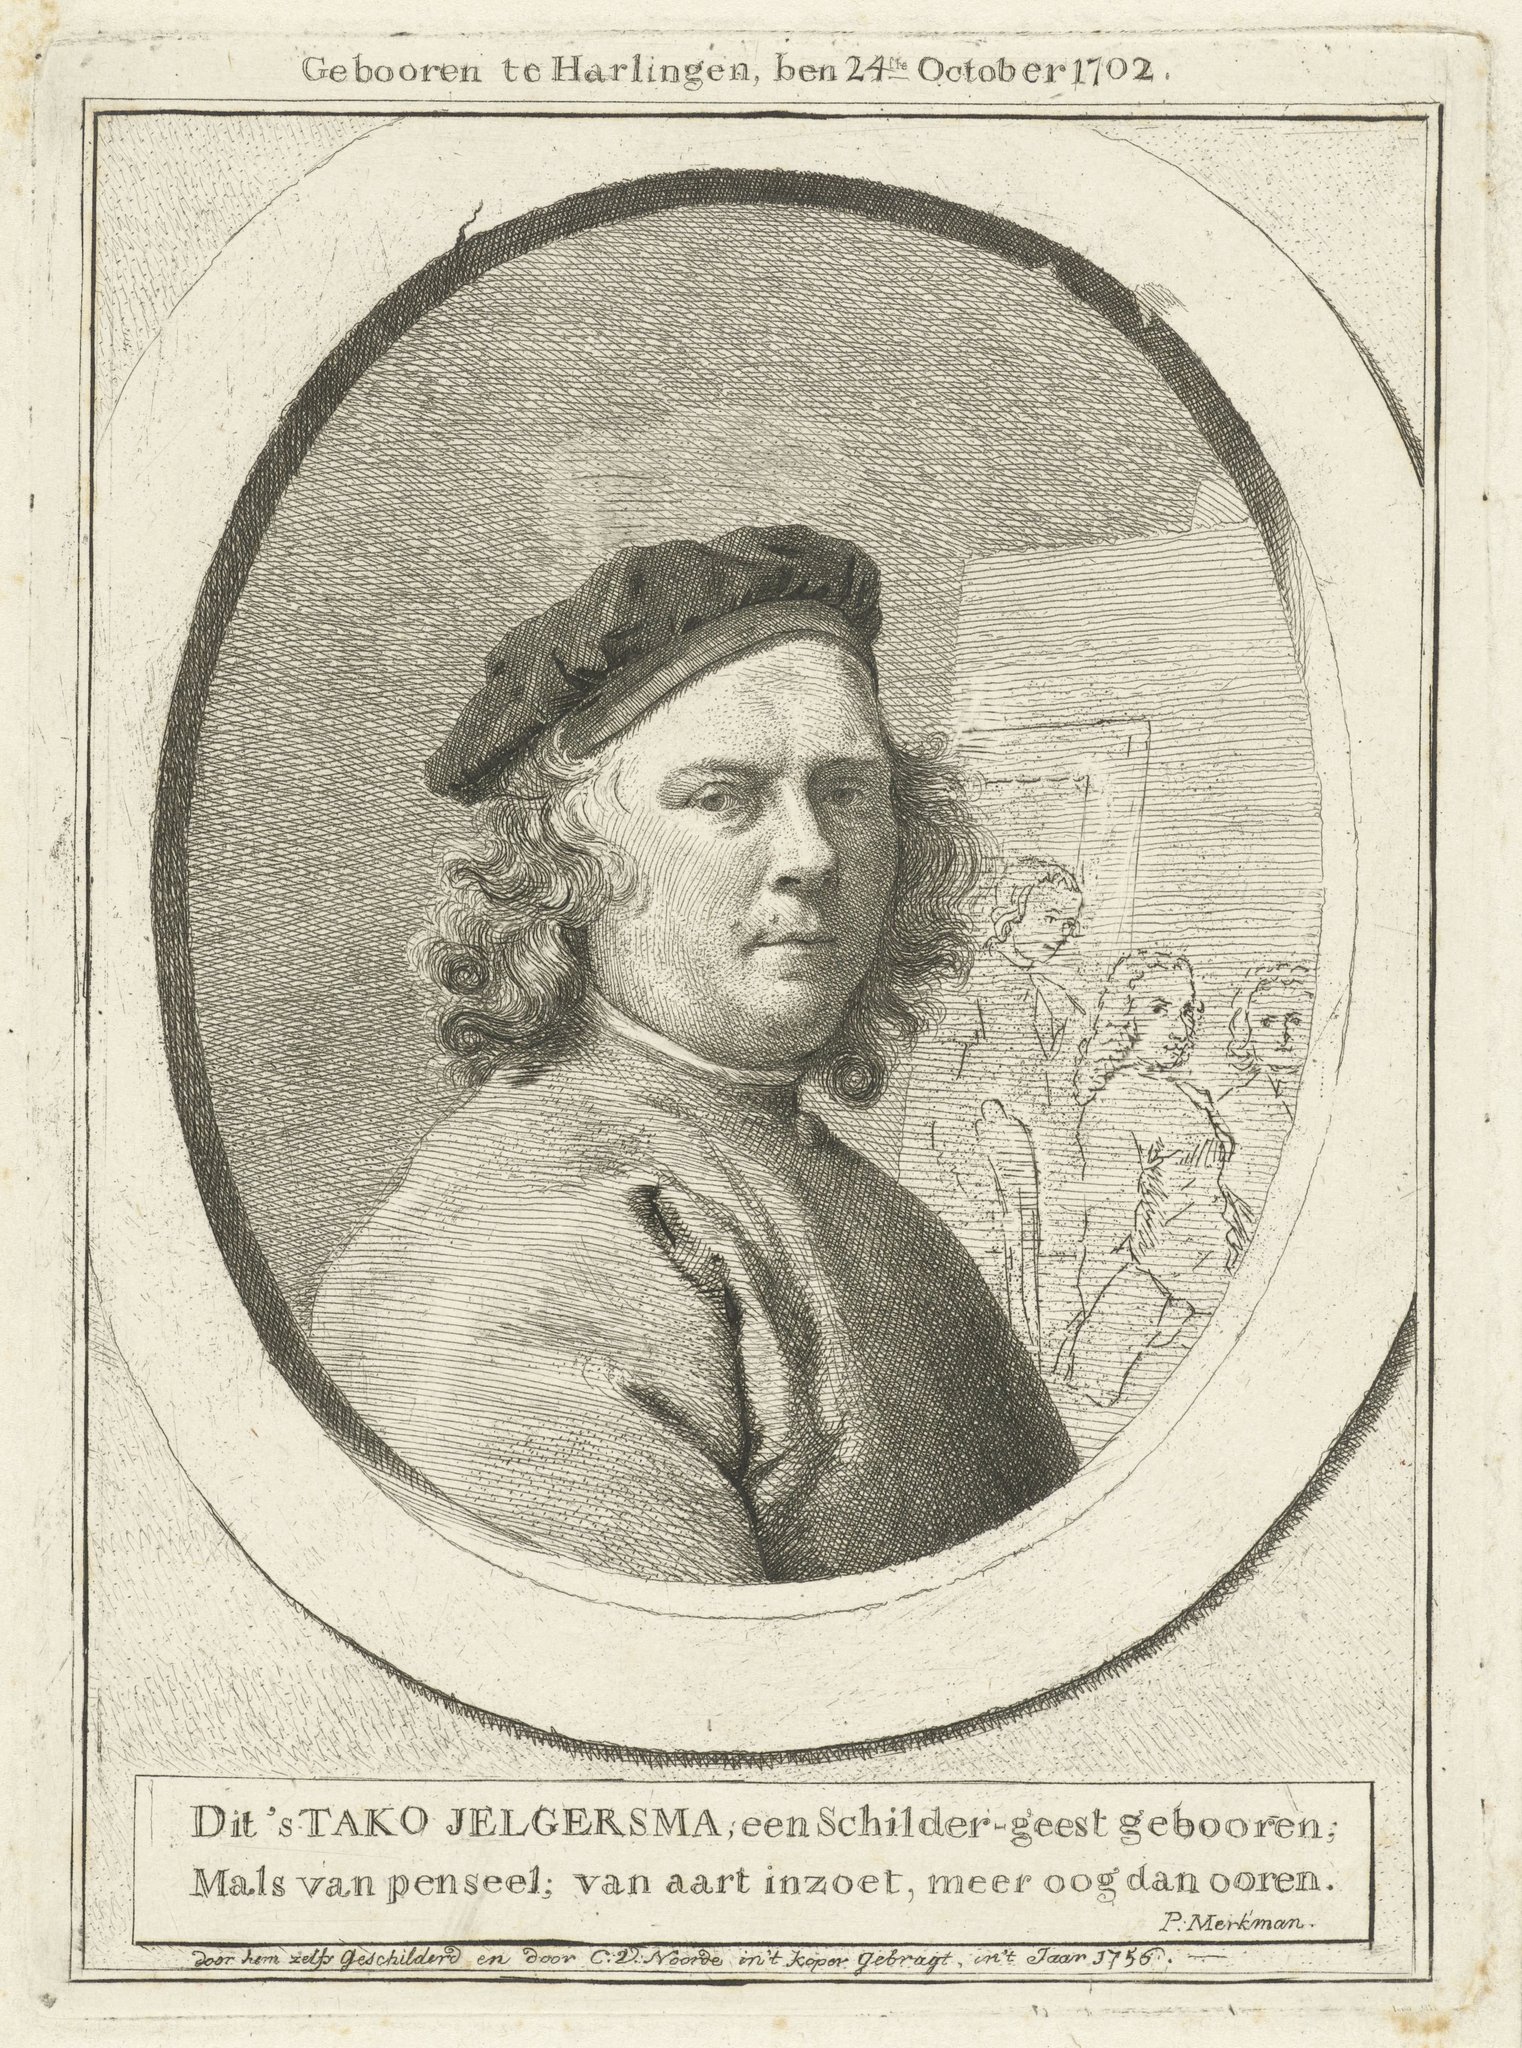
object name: print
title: Portret van Tako Hajo Jelgersma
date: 1756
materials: paper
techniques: etching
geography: haarlem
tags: harlingen, painter, draughtsman, tako hajo jelgersma, portrait, self-portrait of artist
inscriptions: collector's mark: Lugt 240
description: Portret van kunstenaar Tako Hajo Jelgersma met een baret op zijn hoofd voor een schilderij op een ezel.